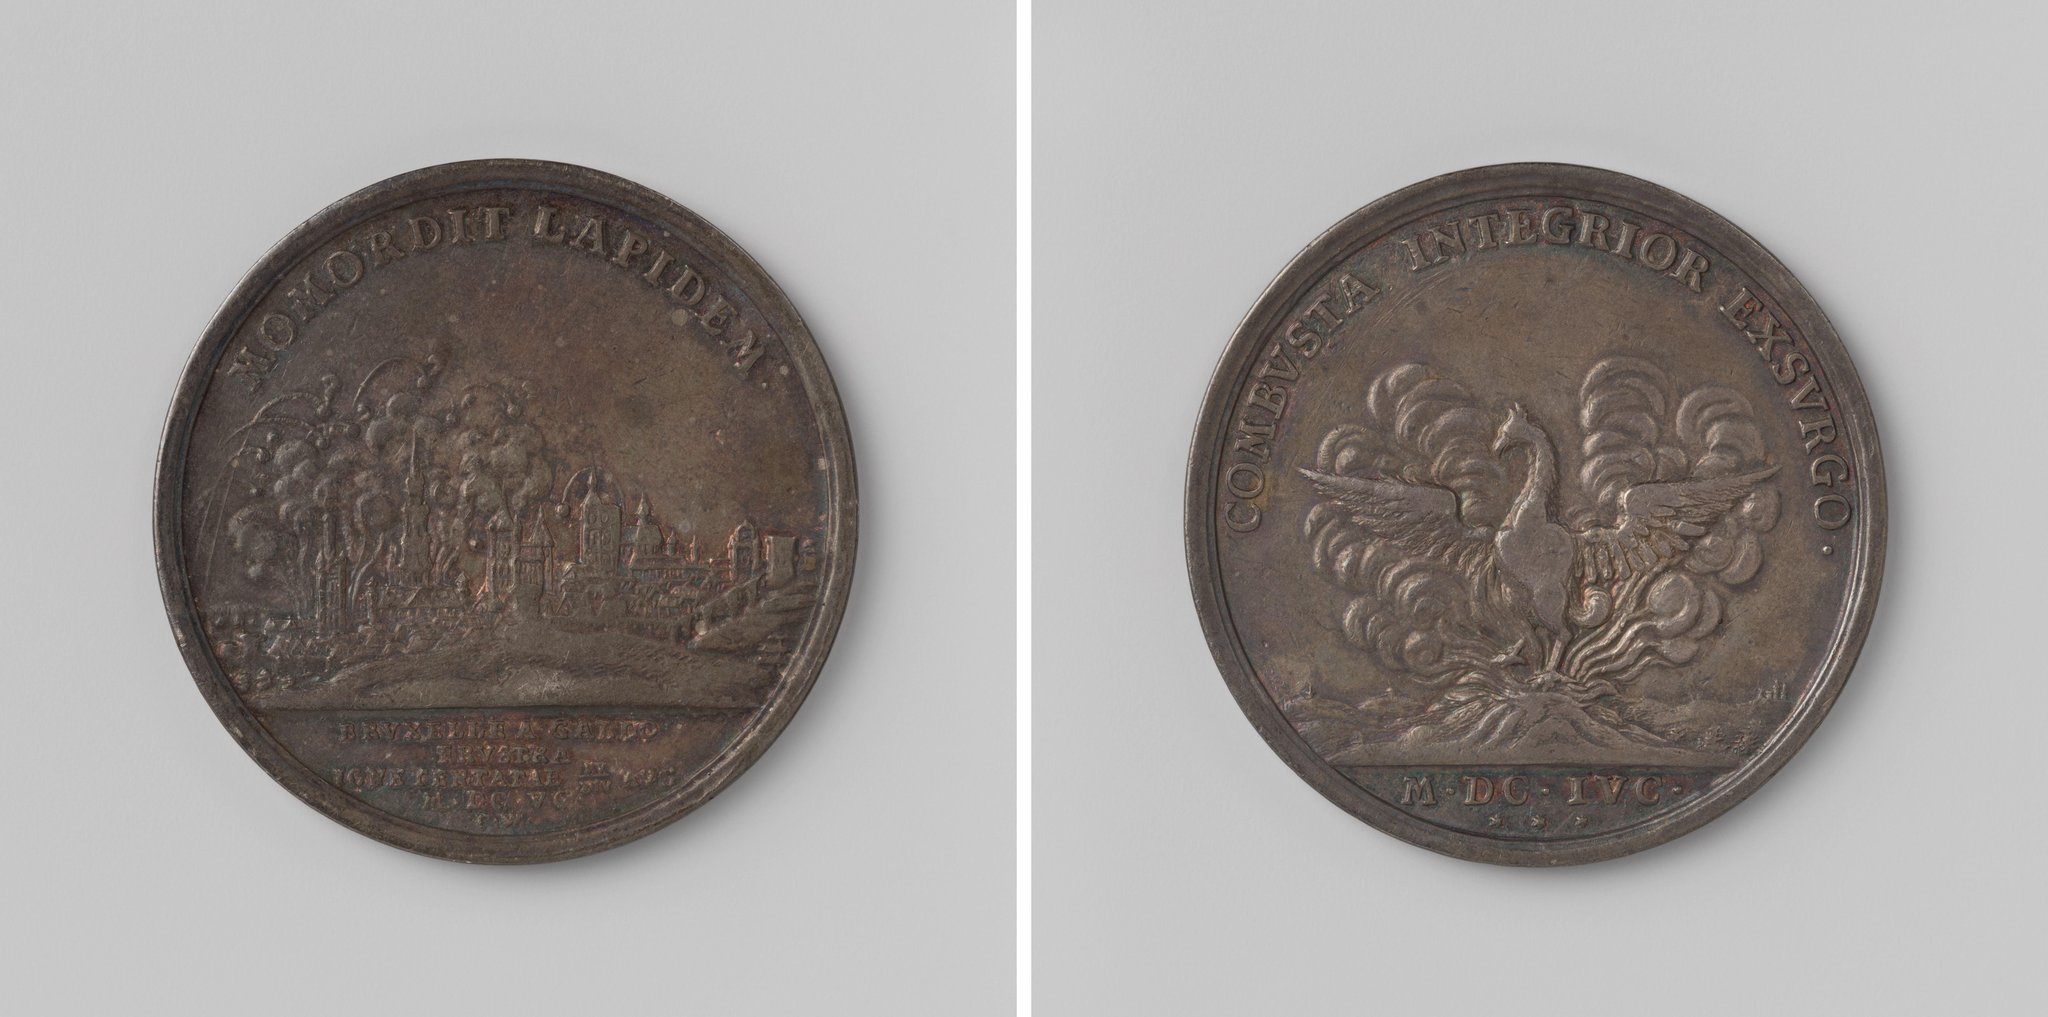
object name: history medal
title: Brussel opnieuw opgebouwd na het Franse bombardement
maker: christian wermuth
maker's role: medailleur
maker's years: 1661-1739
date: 1696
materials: silver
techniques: striking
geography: gotha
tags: brussels